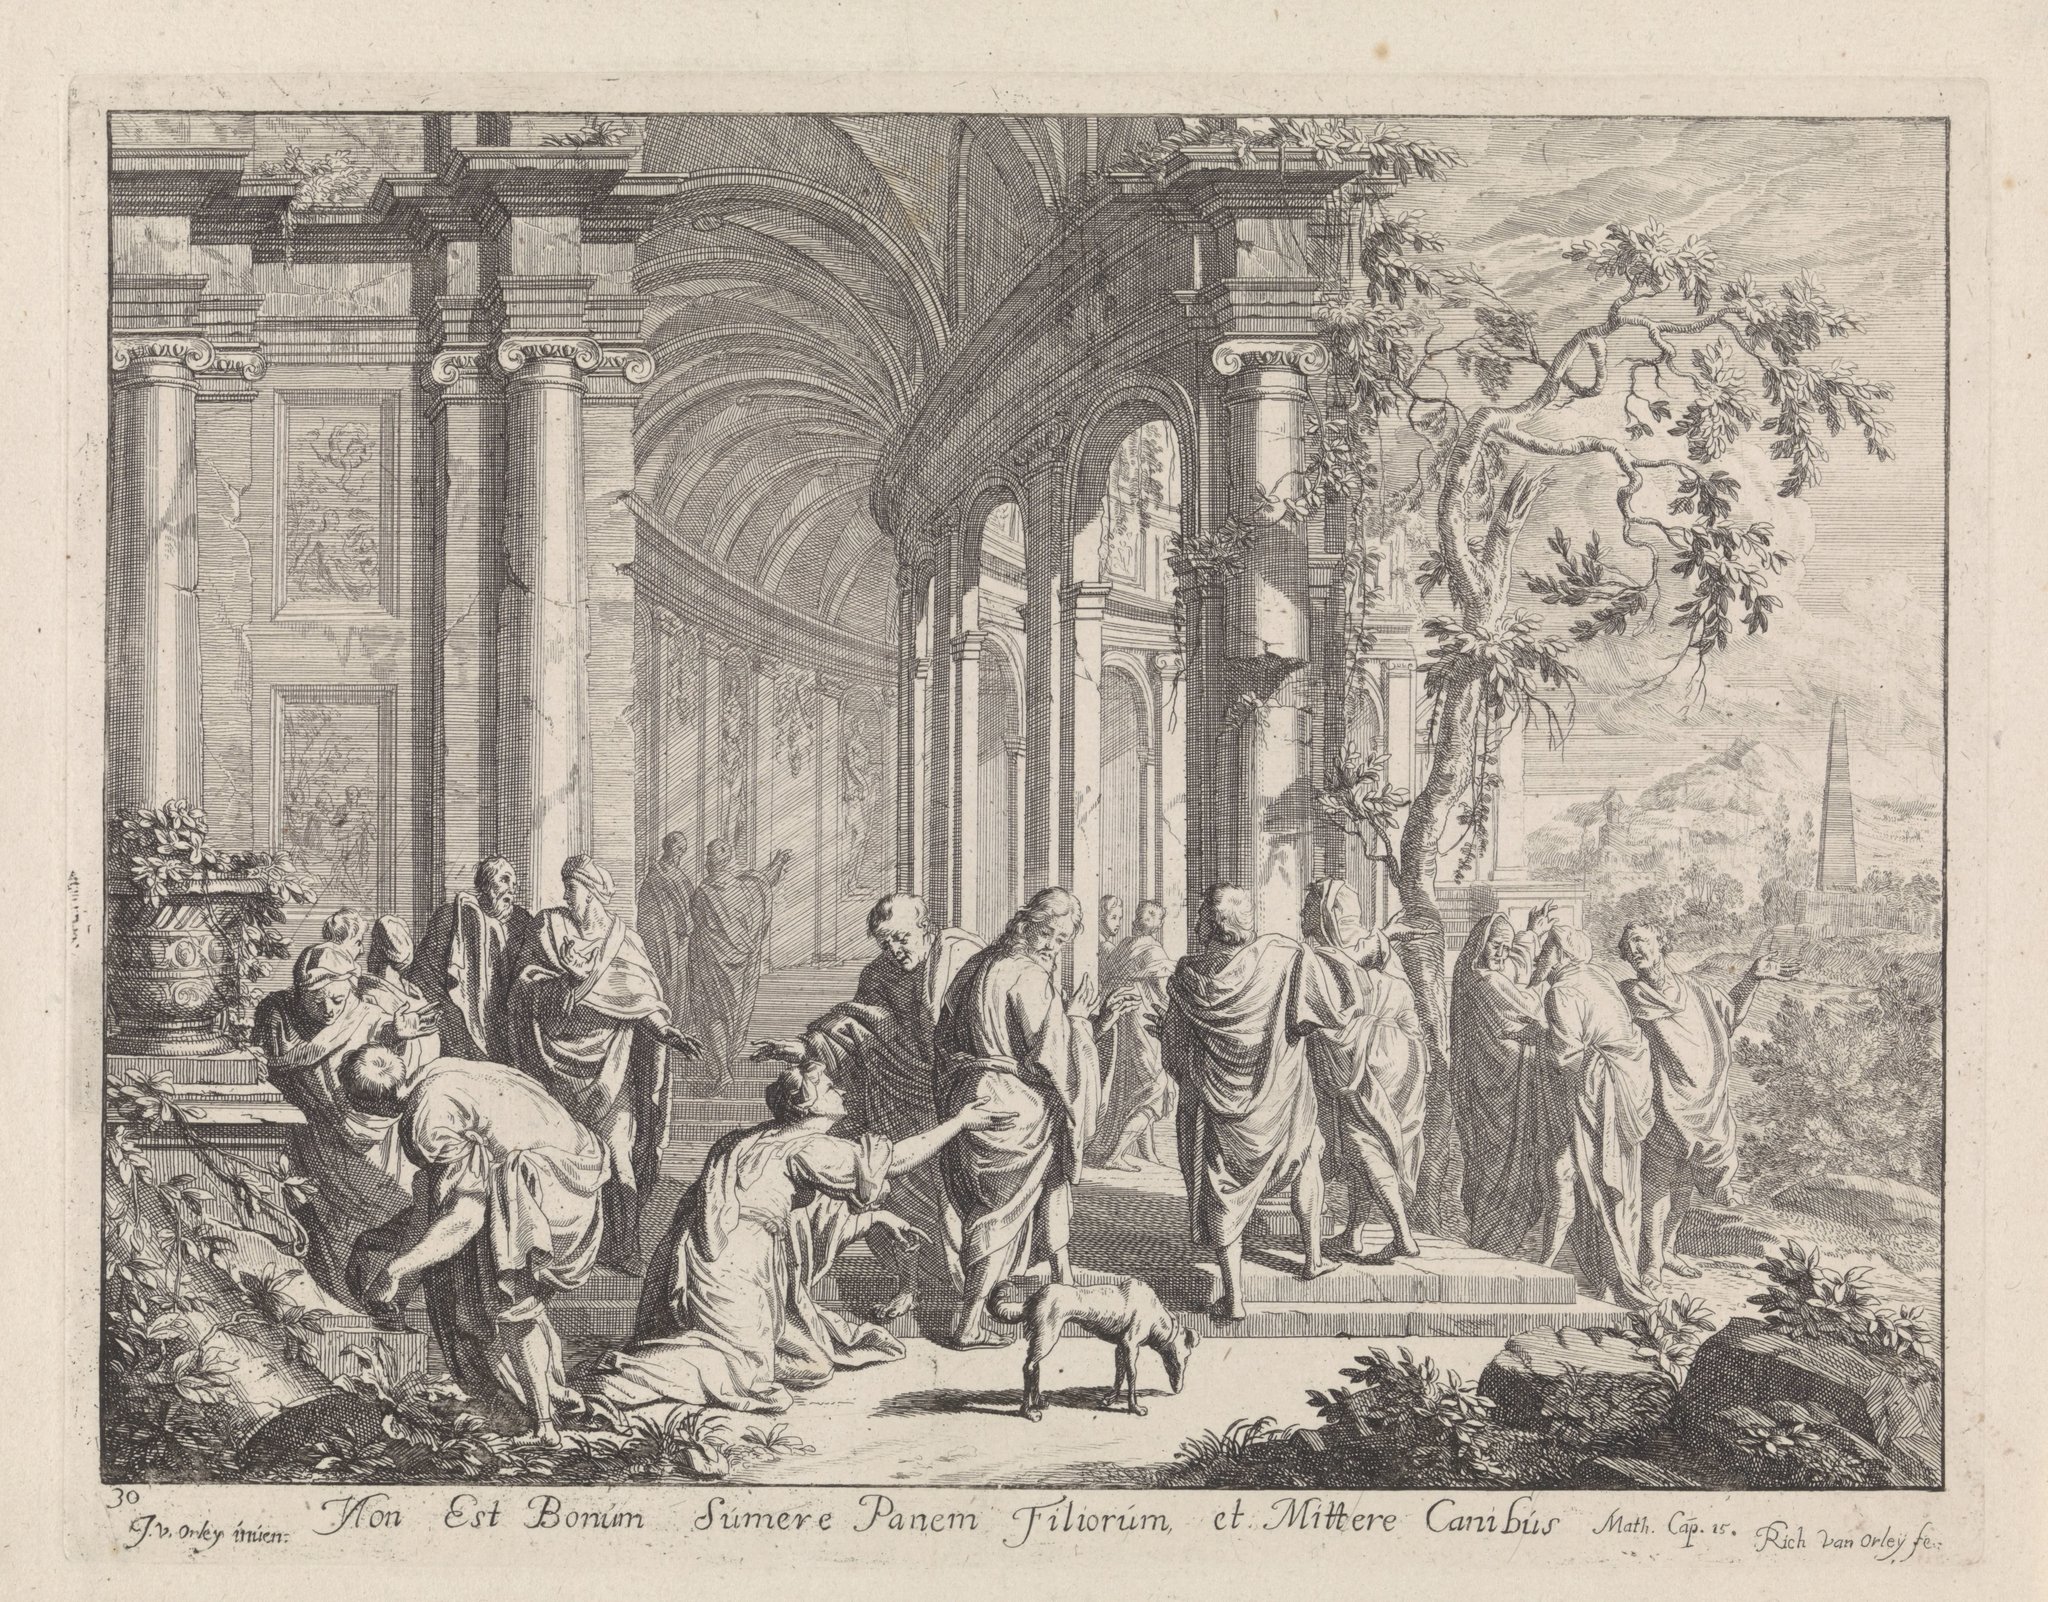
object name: print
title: Scènes uit het Nieuwe Testament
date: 1685-1700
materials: paper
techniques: engraving, etching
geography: brussels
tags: a canaanite woman kneels before christ, asking him to heal her daughter; the metaphor of the dogs and bread (matthew 15:21-28; mark 7:24-30)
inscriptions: collector's mark: Lugt 240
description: Christus staat met zijn volgelingen aan het begin van een zuilengalerij. Een Kanaänitische vrouw knielt achter hem en verzoekt hem haar te helpen. Haar dochtertje is bezeten van demonen. Een van Christus volgelingen wil haar wegsturen, maar Christus praat met haar. Naast Christus een hond die van de grond eet, een verwijzing naar de gelijkenis die Christus aan de vrouw verteld. Onder de afbeelding een Latijns vers uit Mat. 15.